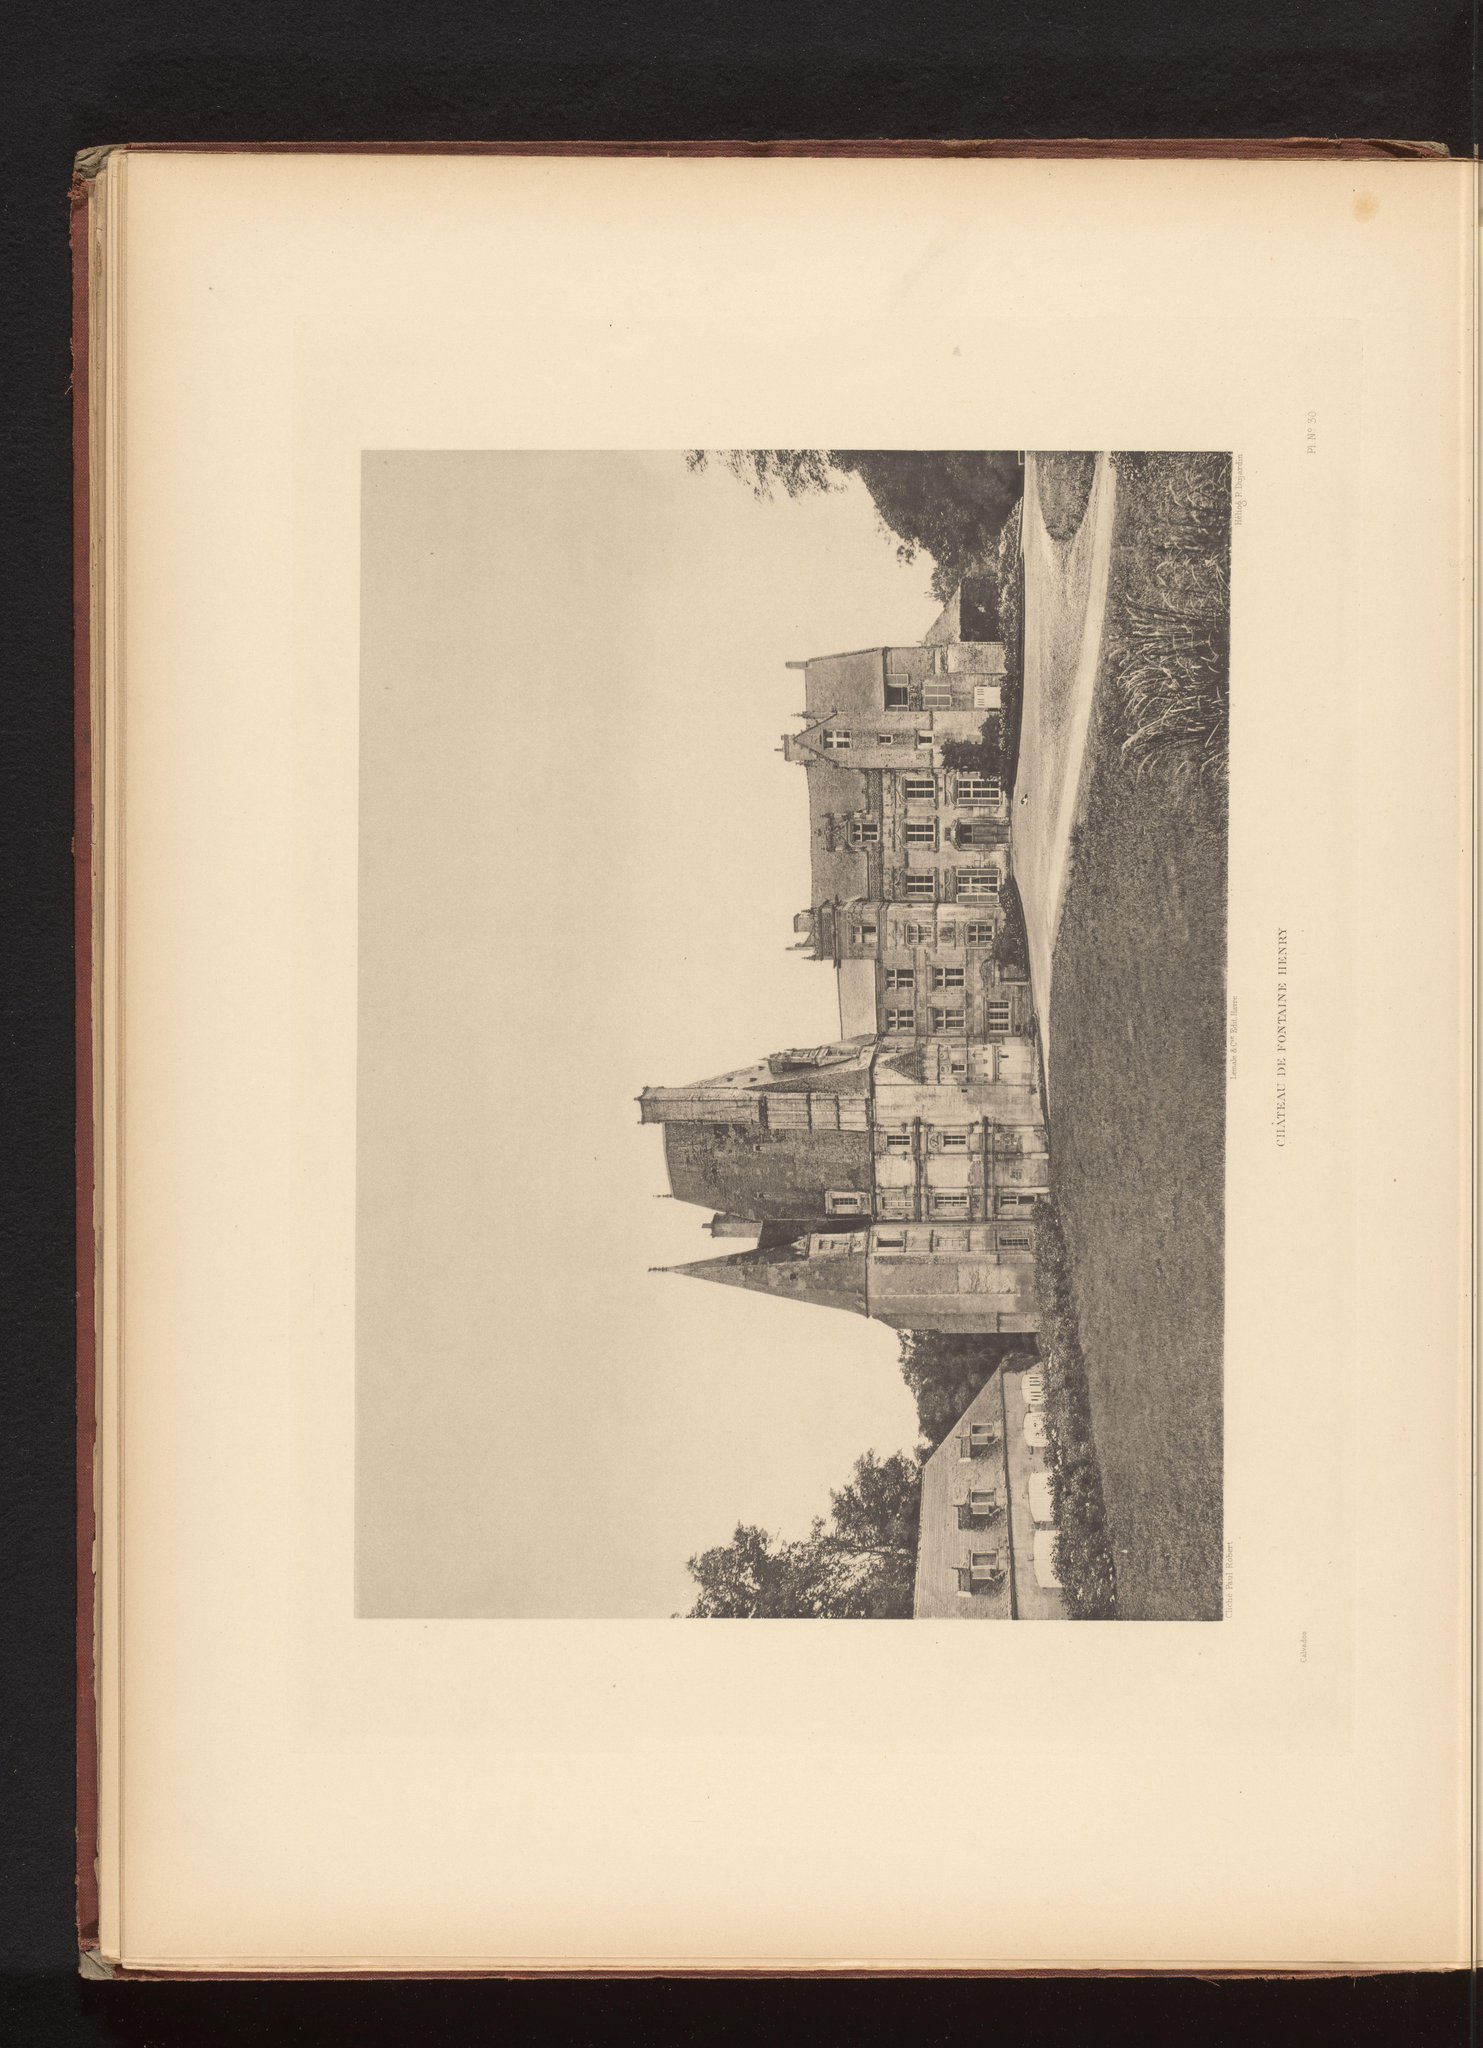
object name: photomechanical print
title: Gezicht op het kasteel in Fontaine-Henry, Normandië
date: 1890-1895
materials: paper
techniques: photoaquatint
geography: le havre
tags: castle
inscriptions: number: ‘Pl. No. 30’, inscription: ‘Calvados.’